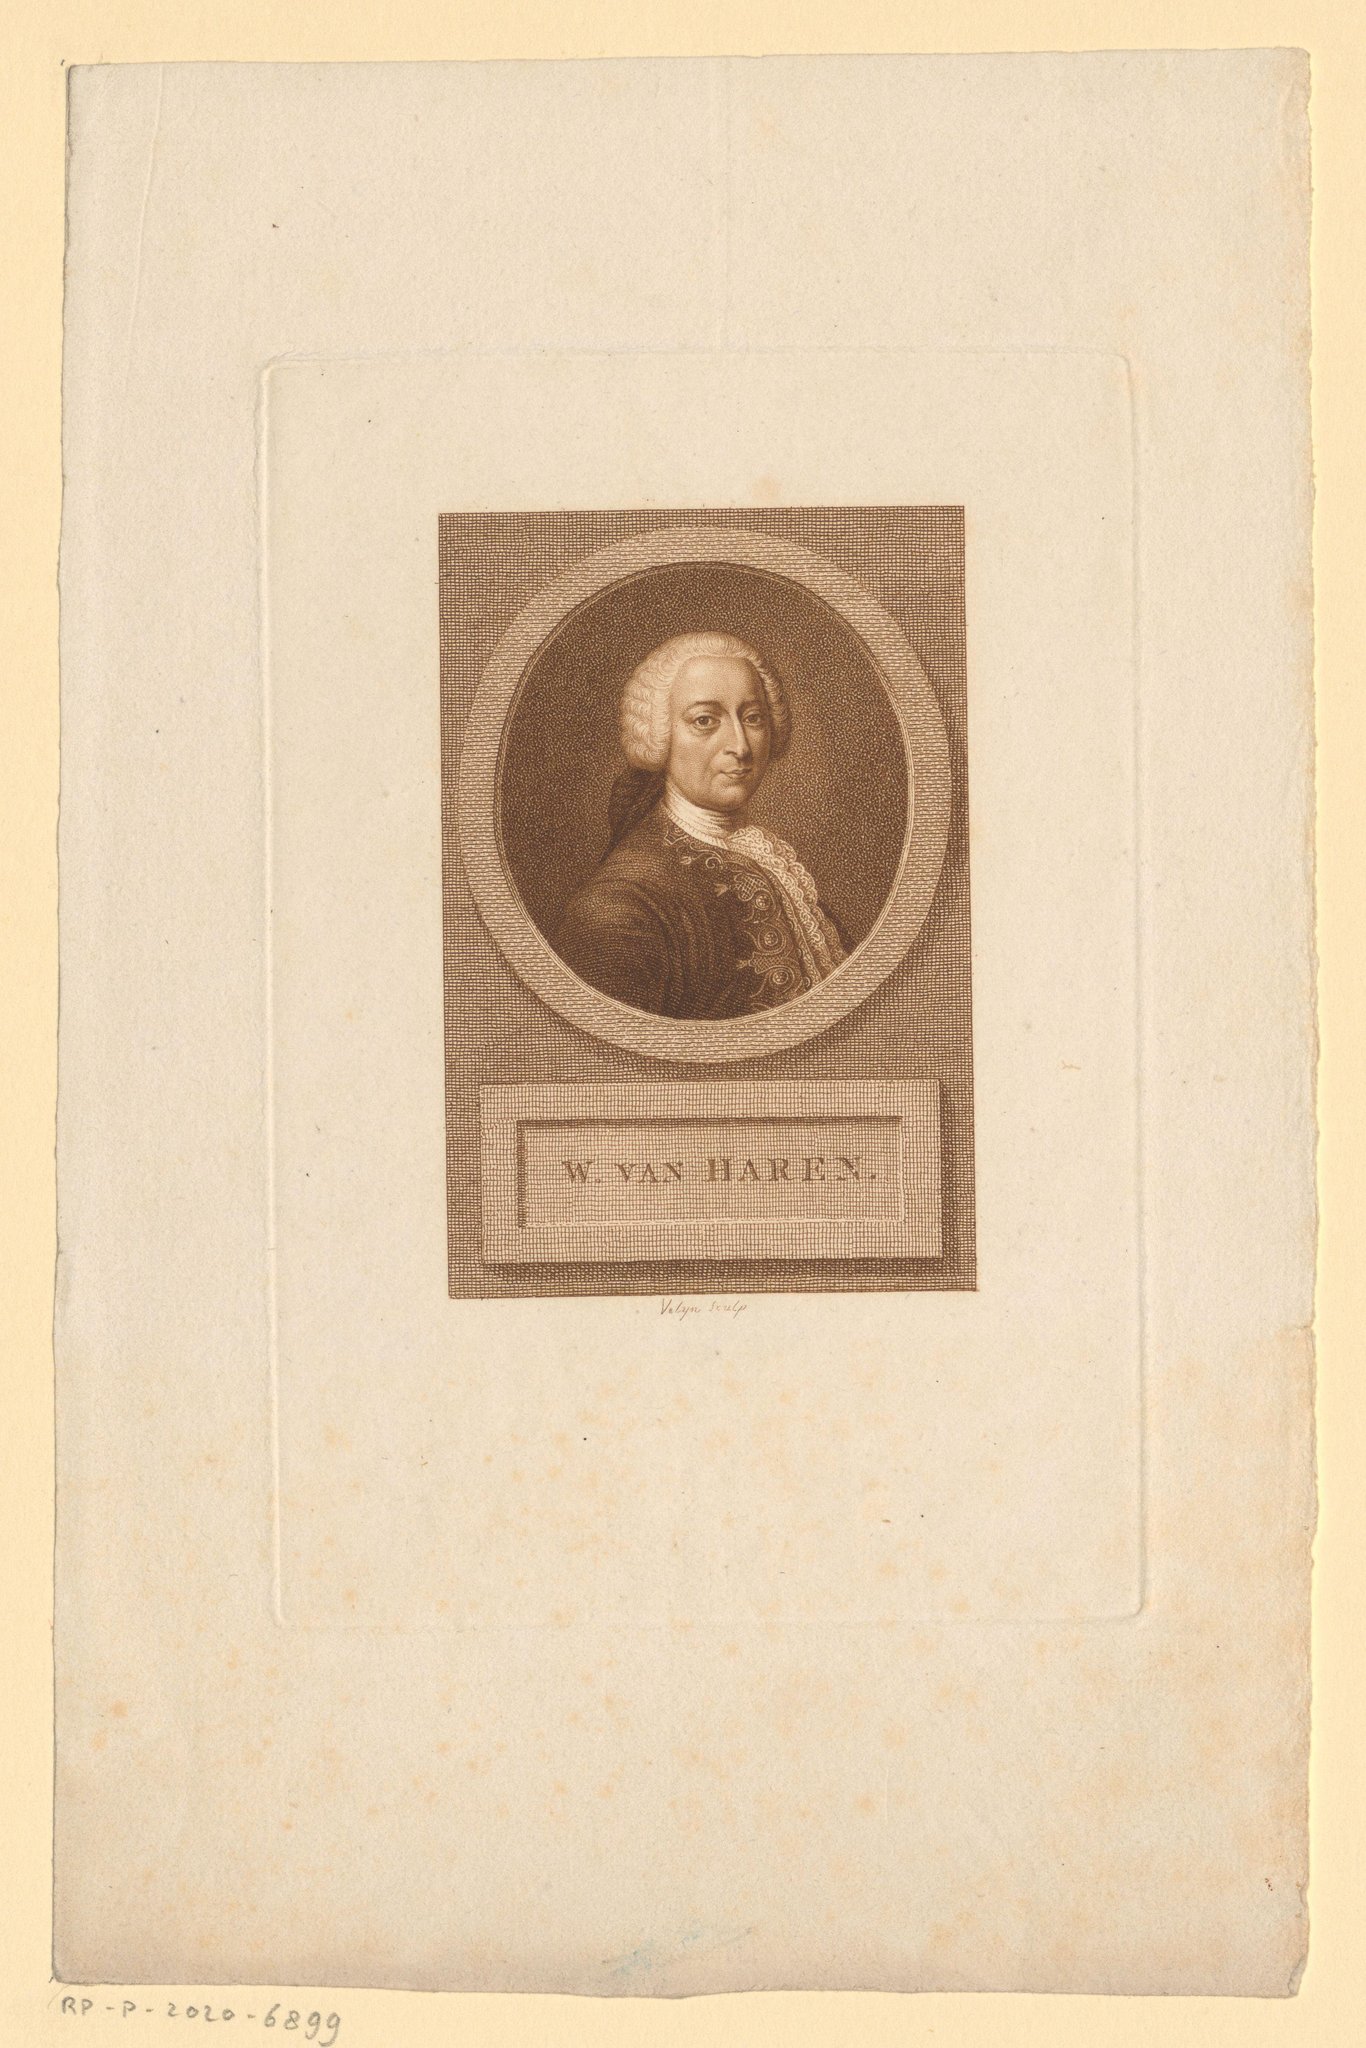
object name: print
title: Portret van Willem van Haren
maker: philippus velijn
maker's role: print maker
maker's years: 1787-1836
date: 1797-1836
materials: paper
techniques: etching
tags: historical persons, writer, poet, author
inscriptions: collector's mark: Lugt 2228